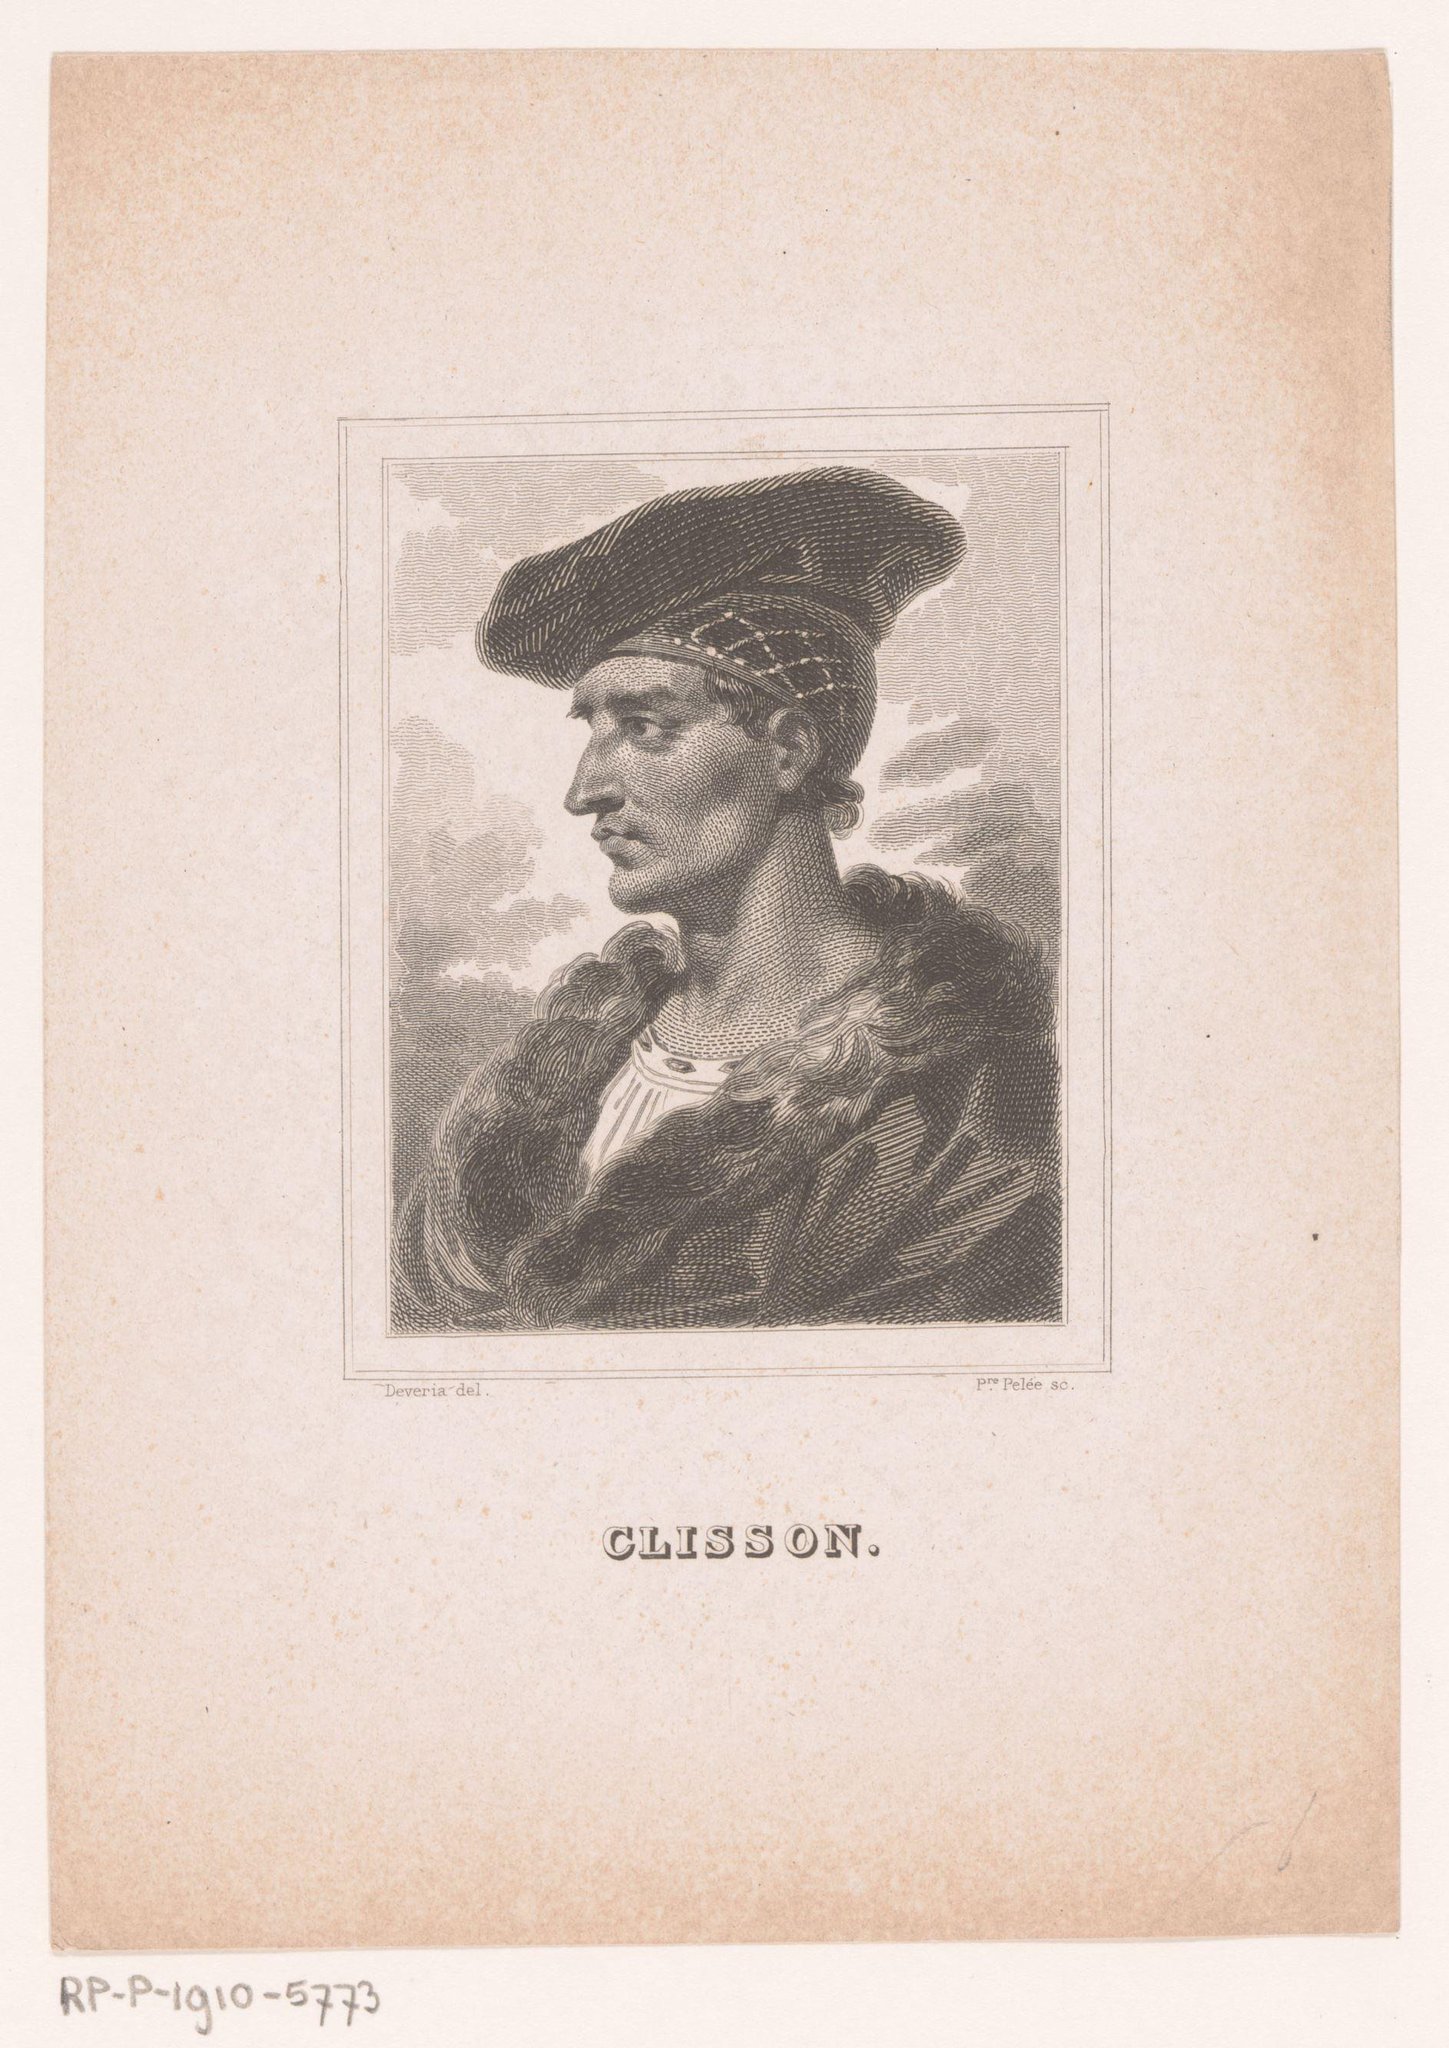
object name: print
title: Portret van Clisson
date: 1811-1871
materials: paper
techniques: engraving, etching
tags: historical persons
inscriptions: collector's mark: Lugt 2228